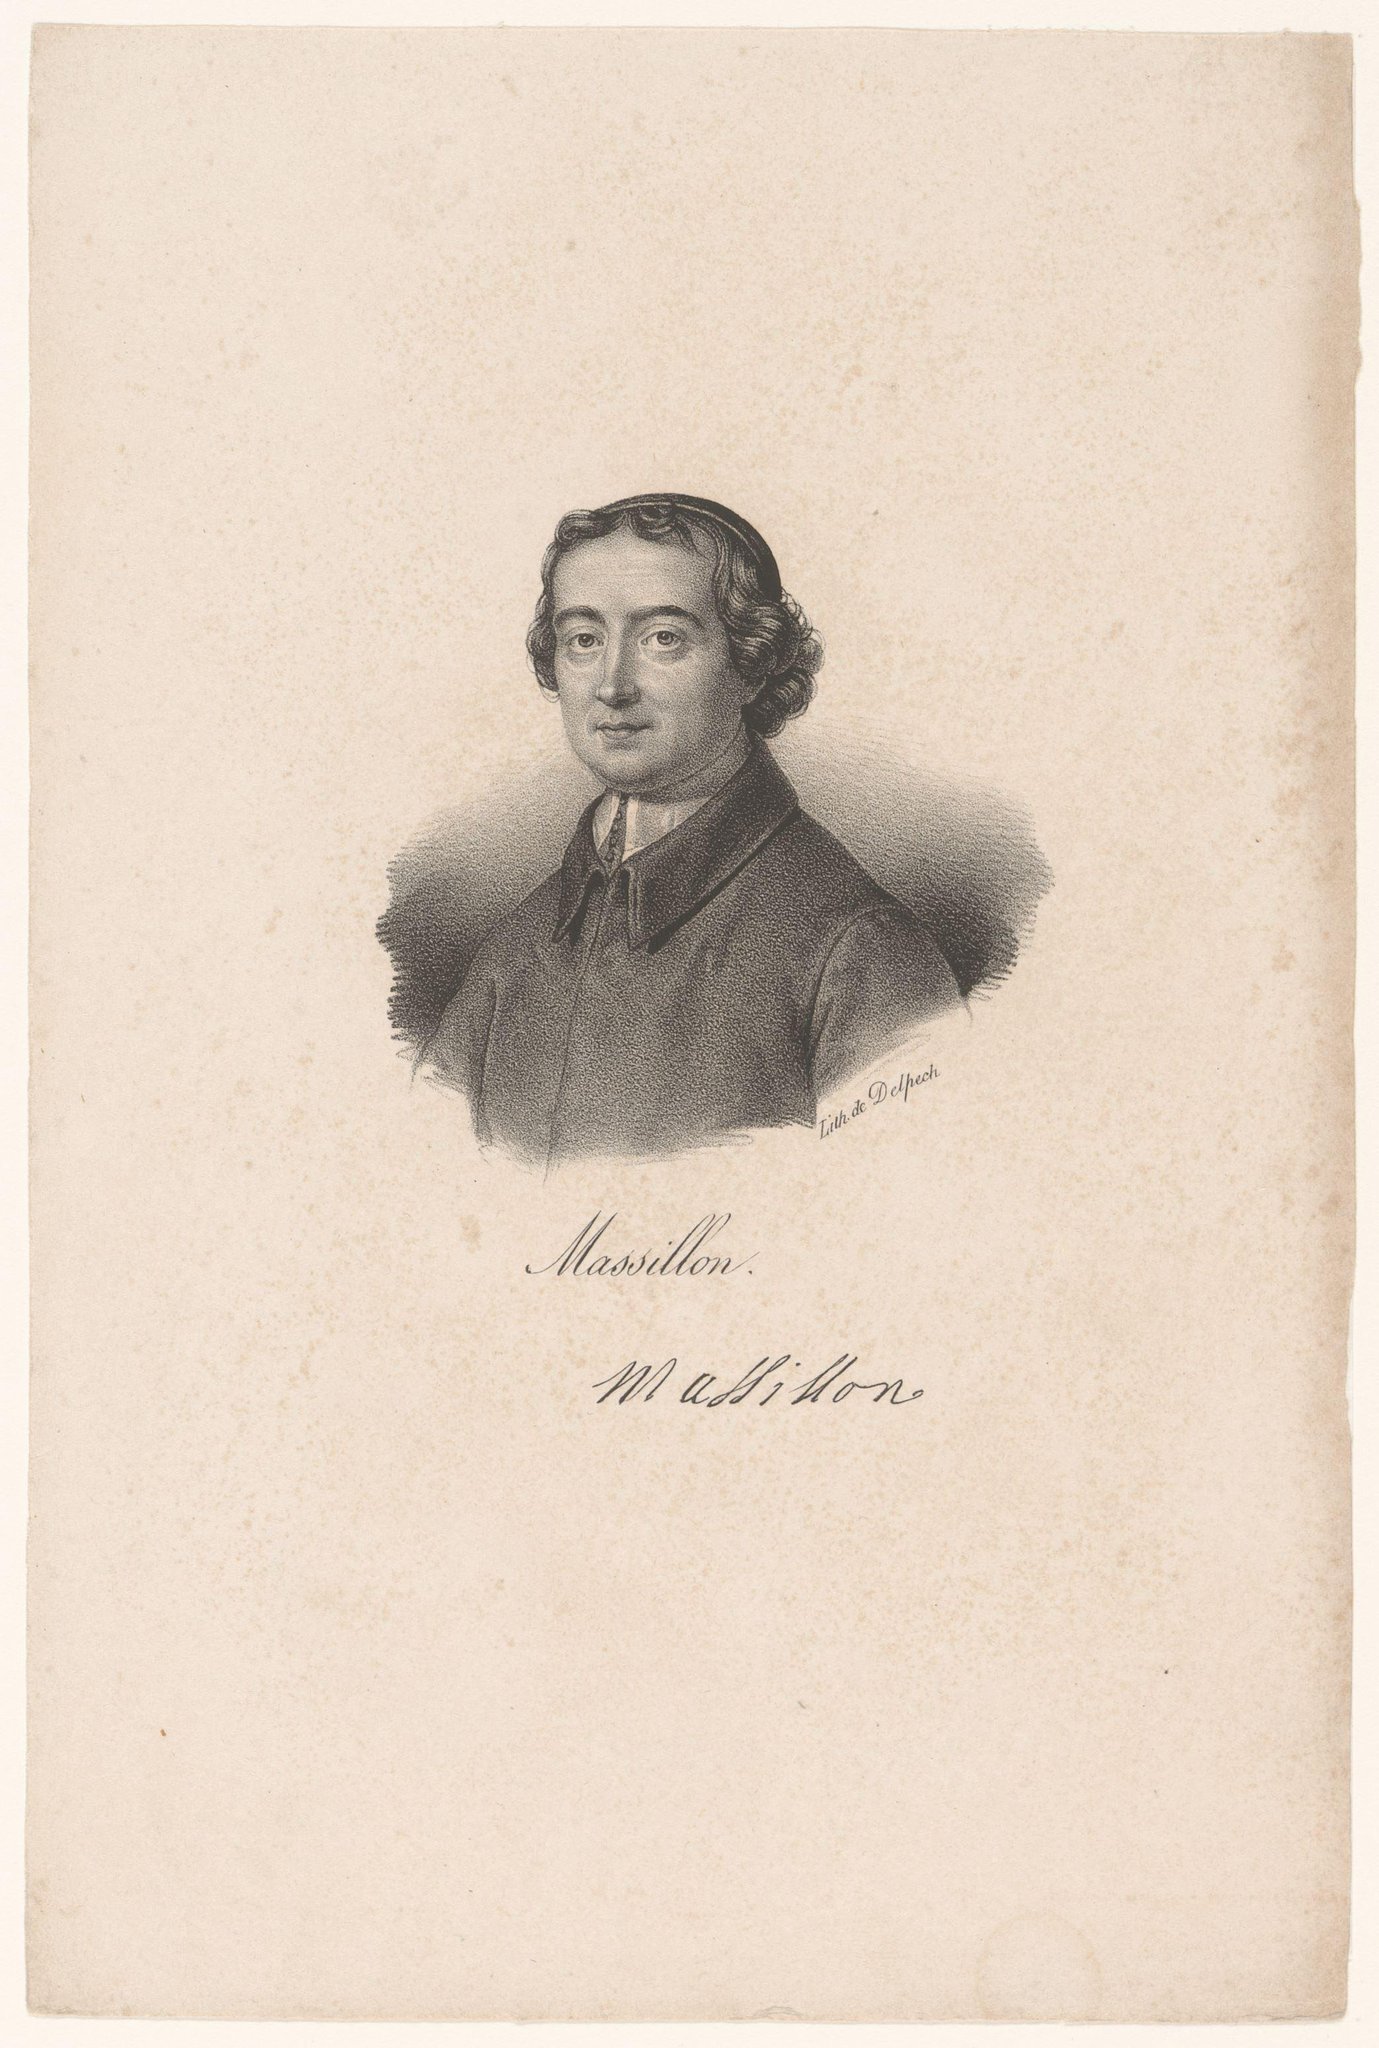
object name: print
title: Portret van Jean-Baptiste Massillon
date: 1818-1842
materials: paper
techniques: lithograph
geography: paris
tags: historical persons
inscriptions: collector's mark: Lugt 2228a